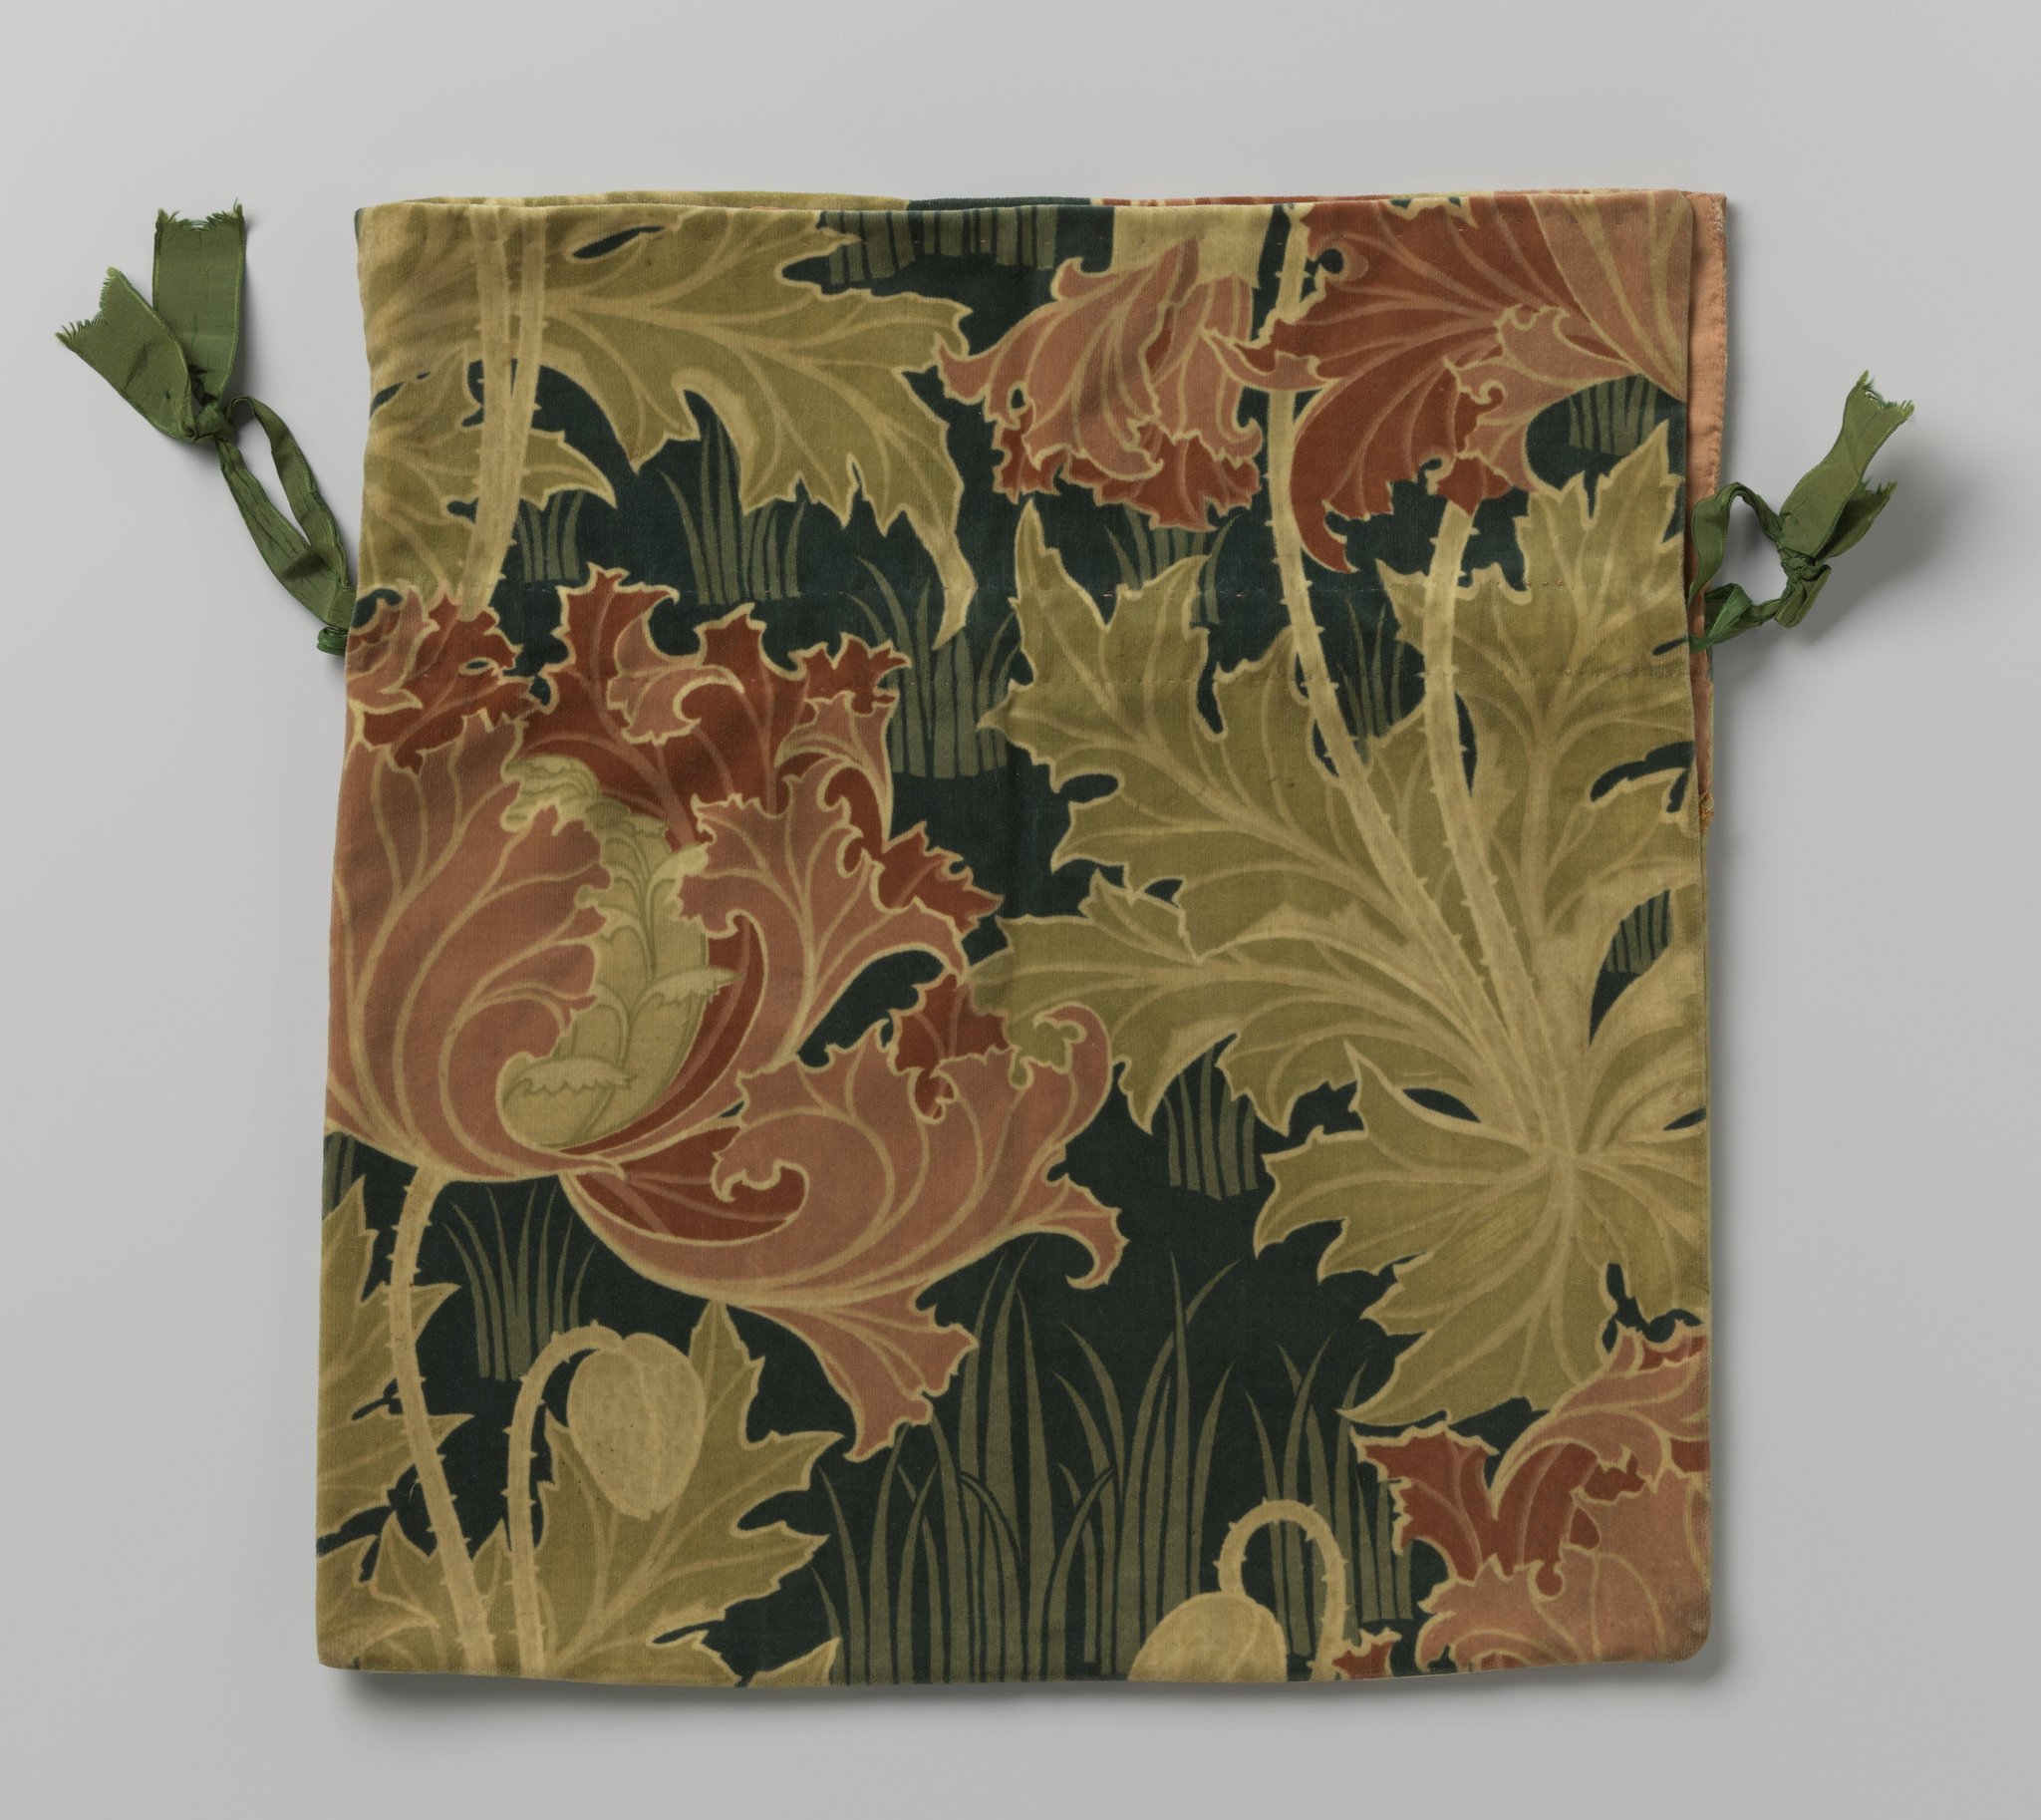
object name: bag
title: Tas van veelkleurig bedrukte trijp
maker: Anonymous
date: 1890-1900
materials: textile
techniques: printing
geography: england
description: Tas van veelkleurig bedrukte trijp. Versierd met papavers en op de achtergrond grasjes. De tas is gevoerd met zalmkleurige zijde en heeft twee groenzijden toe-rijgbandjes.